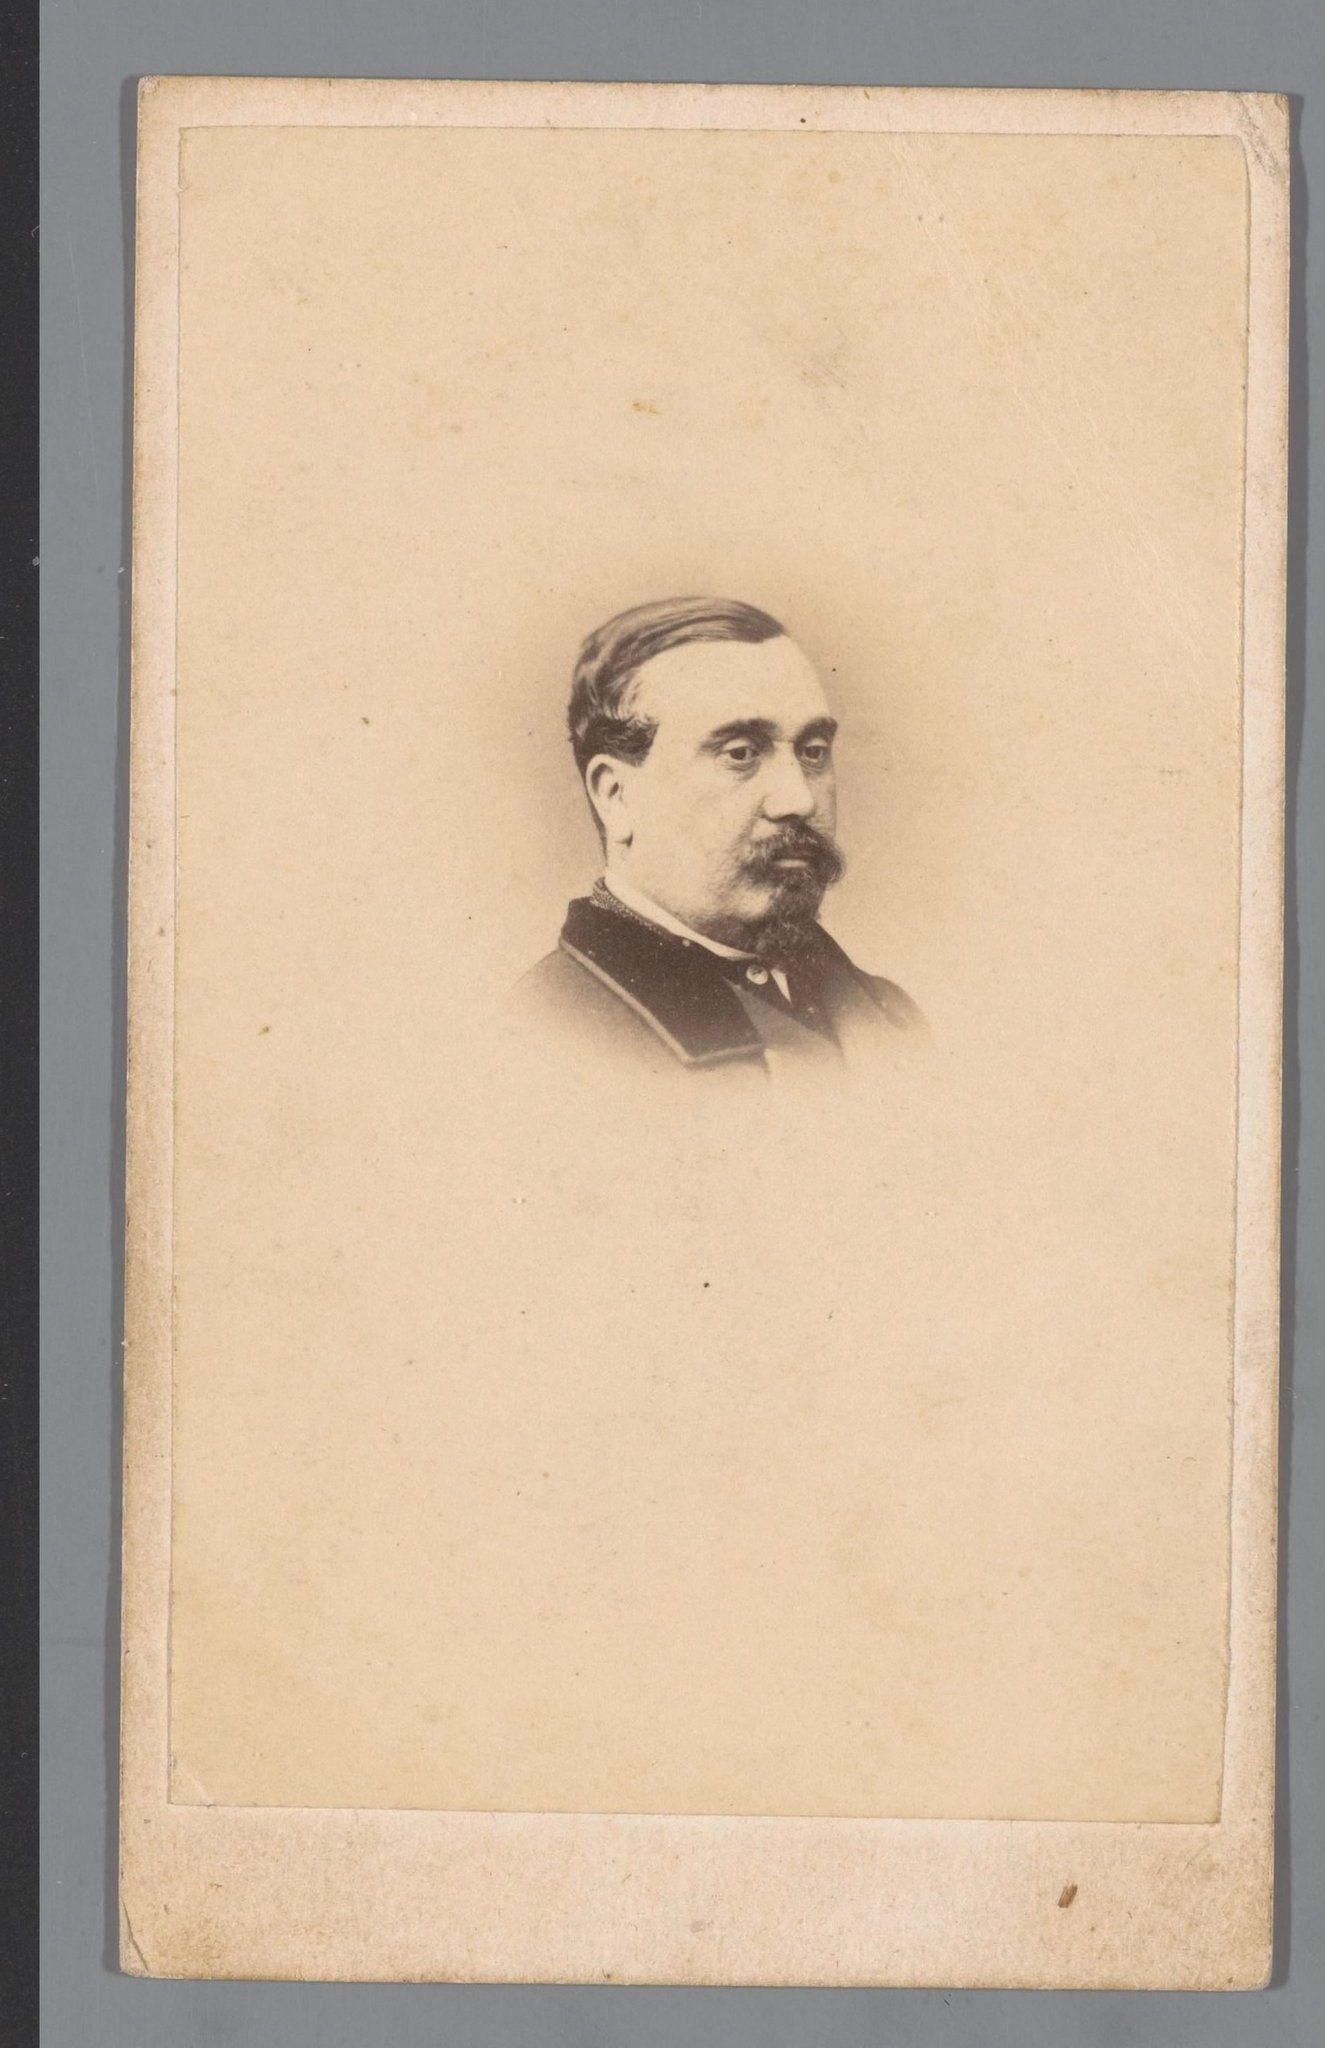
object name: photograph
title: Portret van een man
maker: Anonymous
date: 1850-1899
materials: cardboard, paper, photographic support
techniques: albumen print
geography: rotterdam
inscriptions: annotation: ‘Jules Nobuchow...’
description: Kop van een man met een snor, naar rechts, zonder achtergrond.